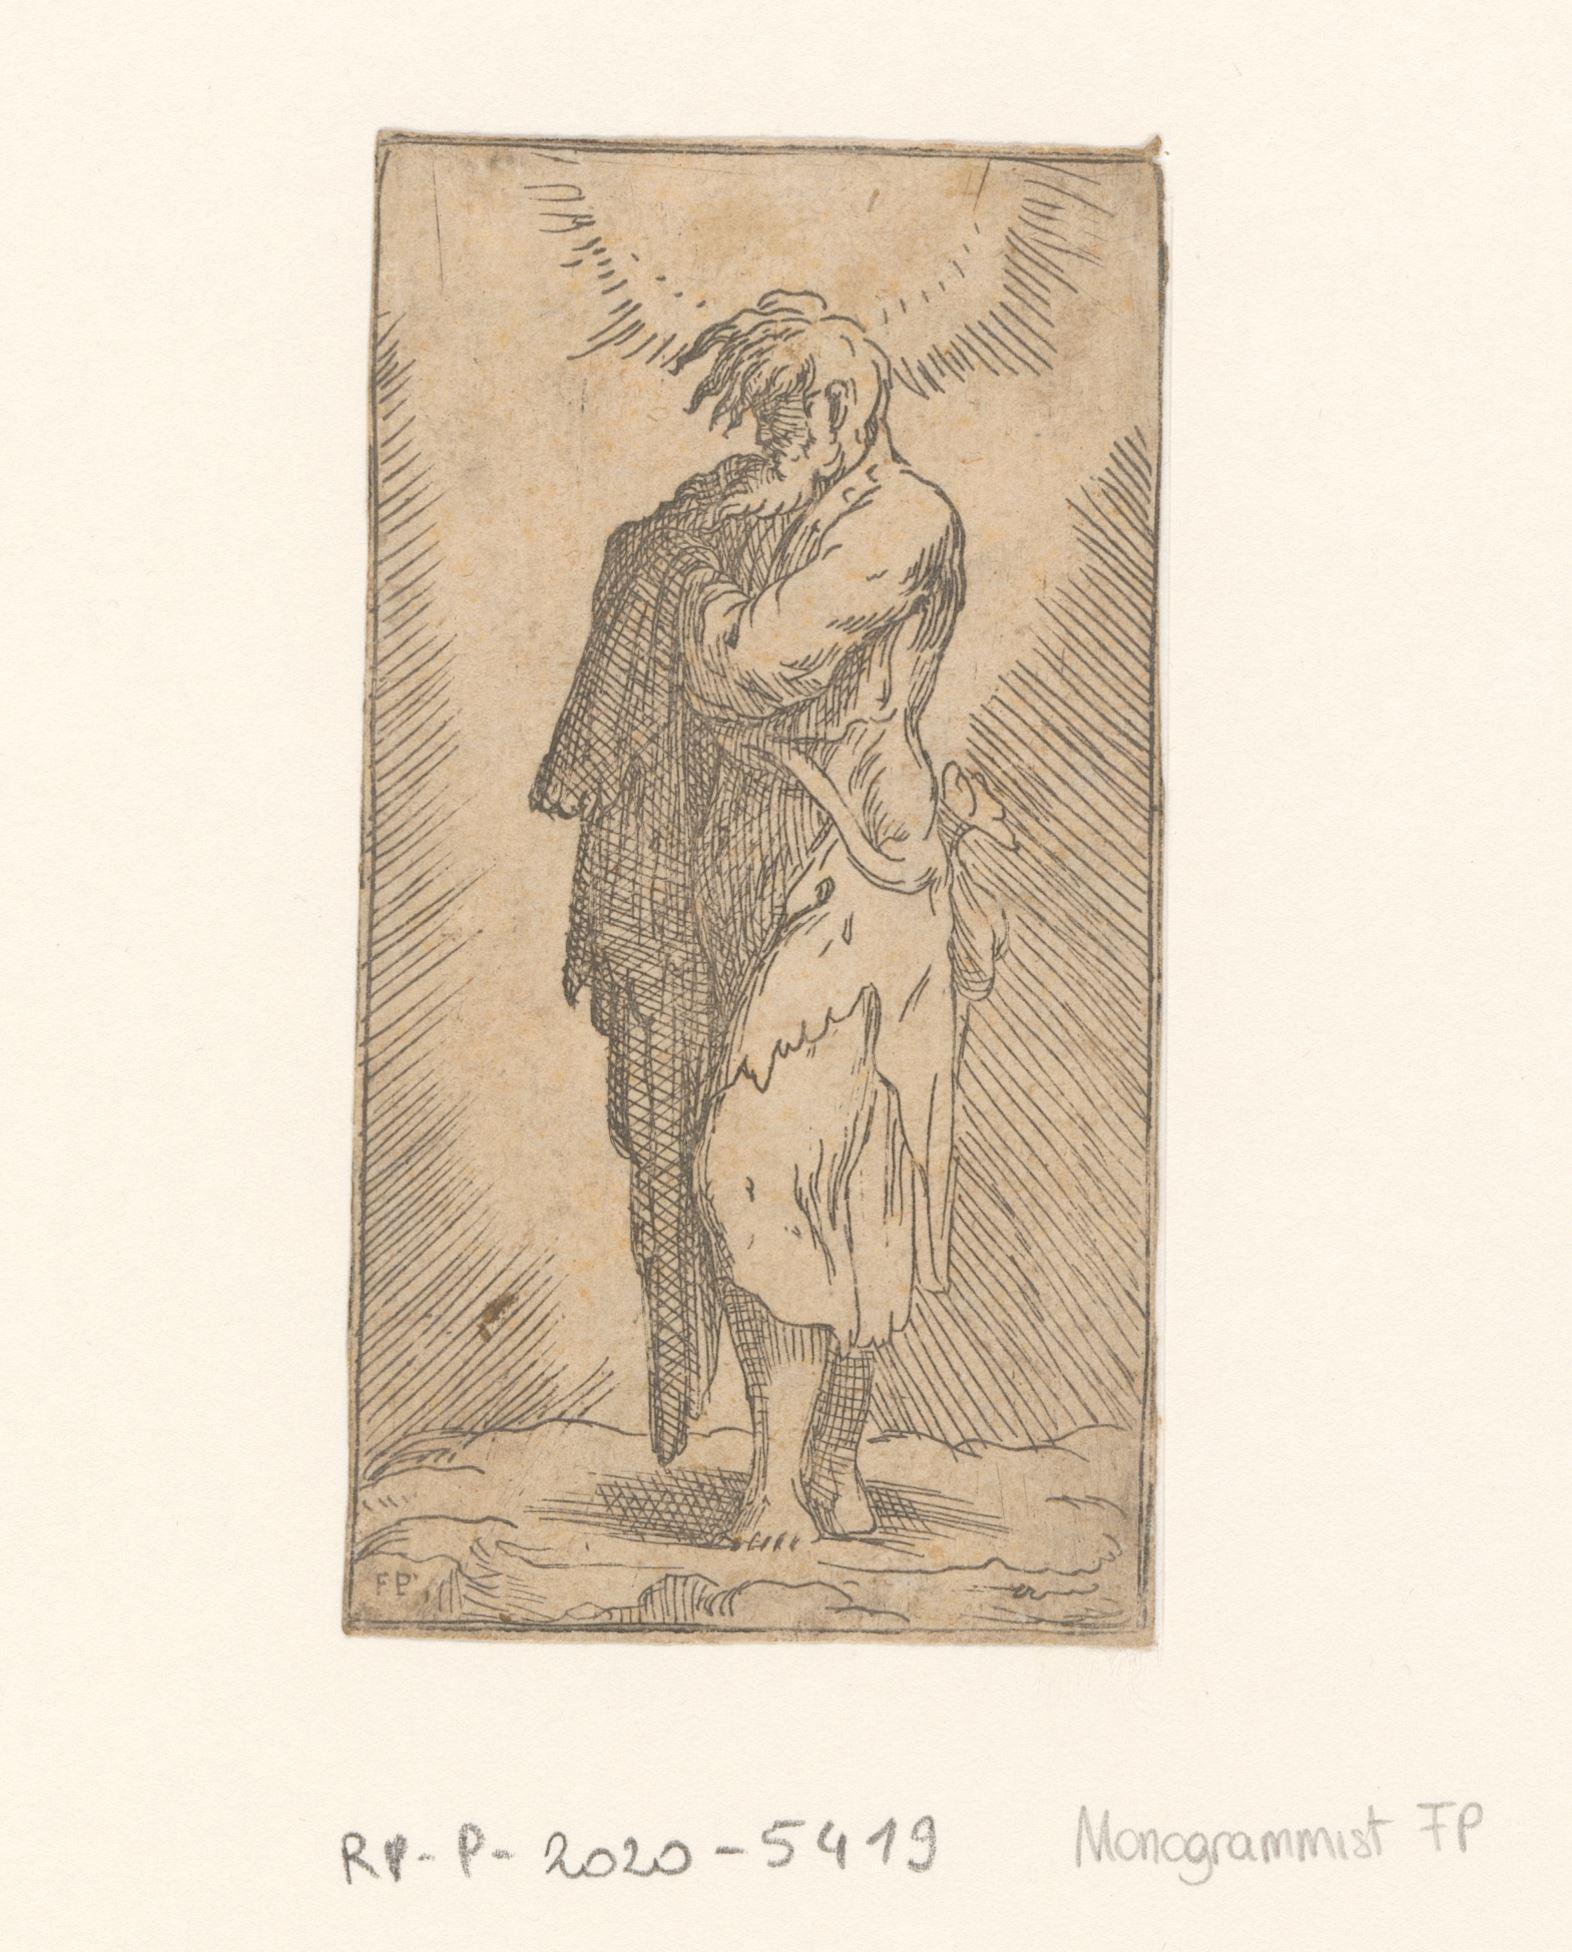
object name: print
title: Christus en de apostelen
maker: monogrammist fp (italië; 16e eeuw)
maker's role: print maker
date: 1520-1600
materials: paper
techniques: etching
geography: italy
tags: the apostle thomas; possible attributes: book, chalice, girdle, heart, lance or spear, scroll, square, stones, the apostle james the less, first bishop of jerusalem; possible attributes: book, fuller's club, scroll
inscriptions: collector's mark: Lugt 2166, inscription: ‘Tadeus’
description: Kopie naar de prent van Schiavone of de houtsnede van Antonio da Trento. Da Trento ontleende het ontwerp aan Parmigianino (zie Bartsch).